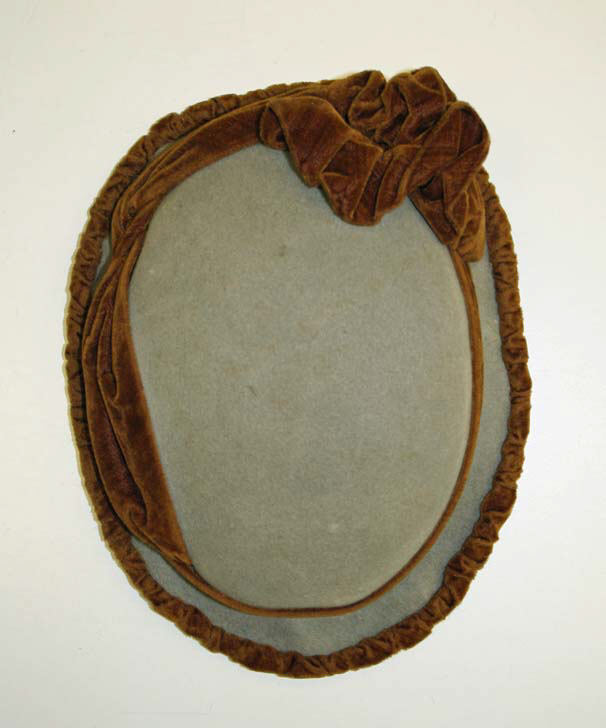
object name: hat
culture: american or european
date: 1867-1869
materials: wool